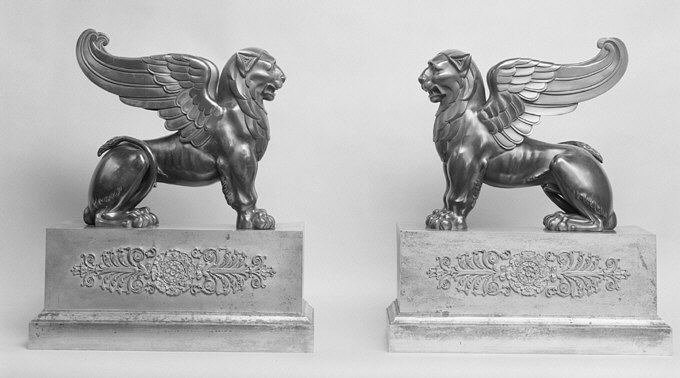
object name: andiron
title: Winged lions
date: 1801-1825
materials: bronze, gilt bronze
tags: lions